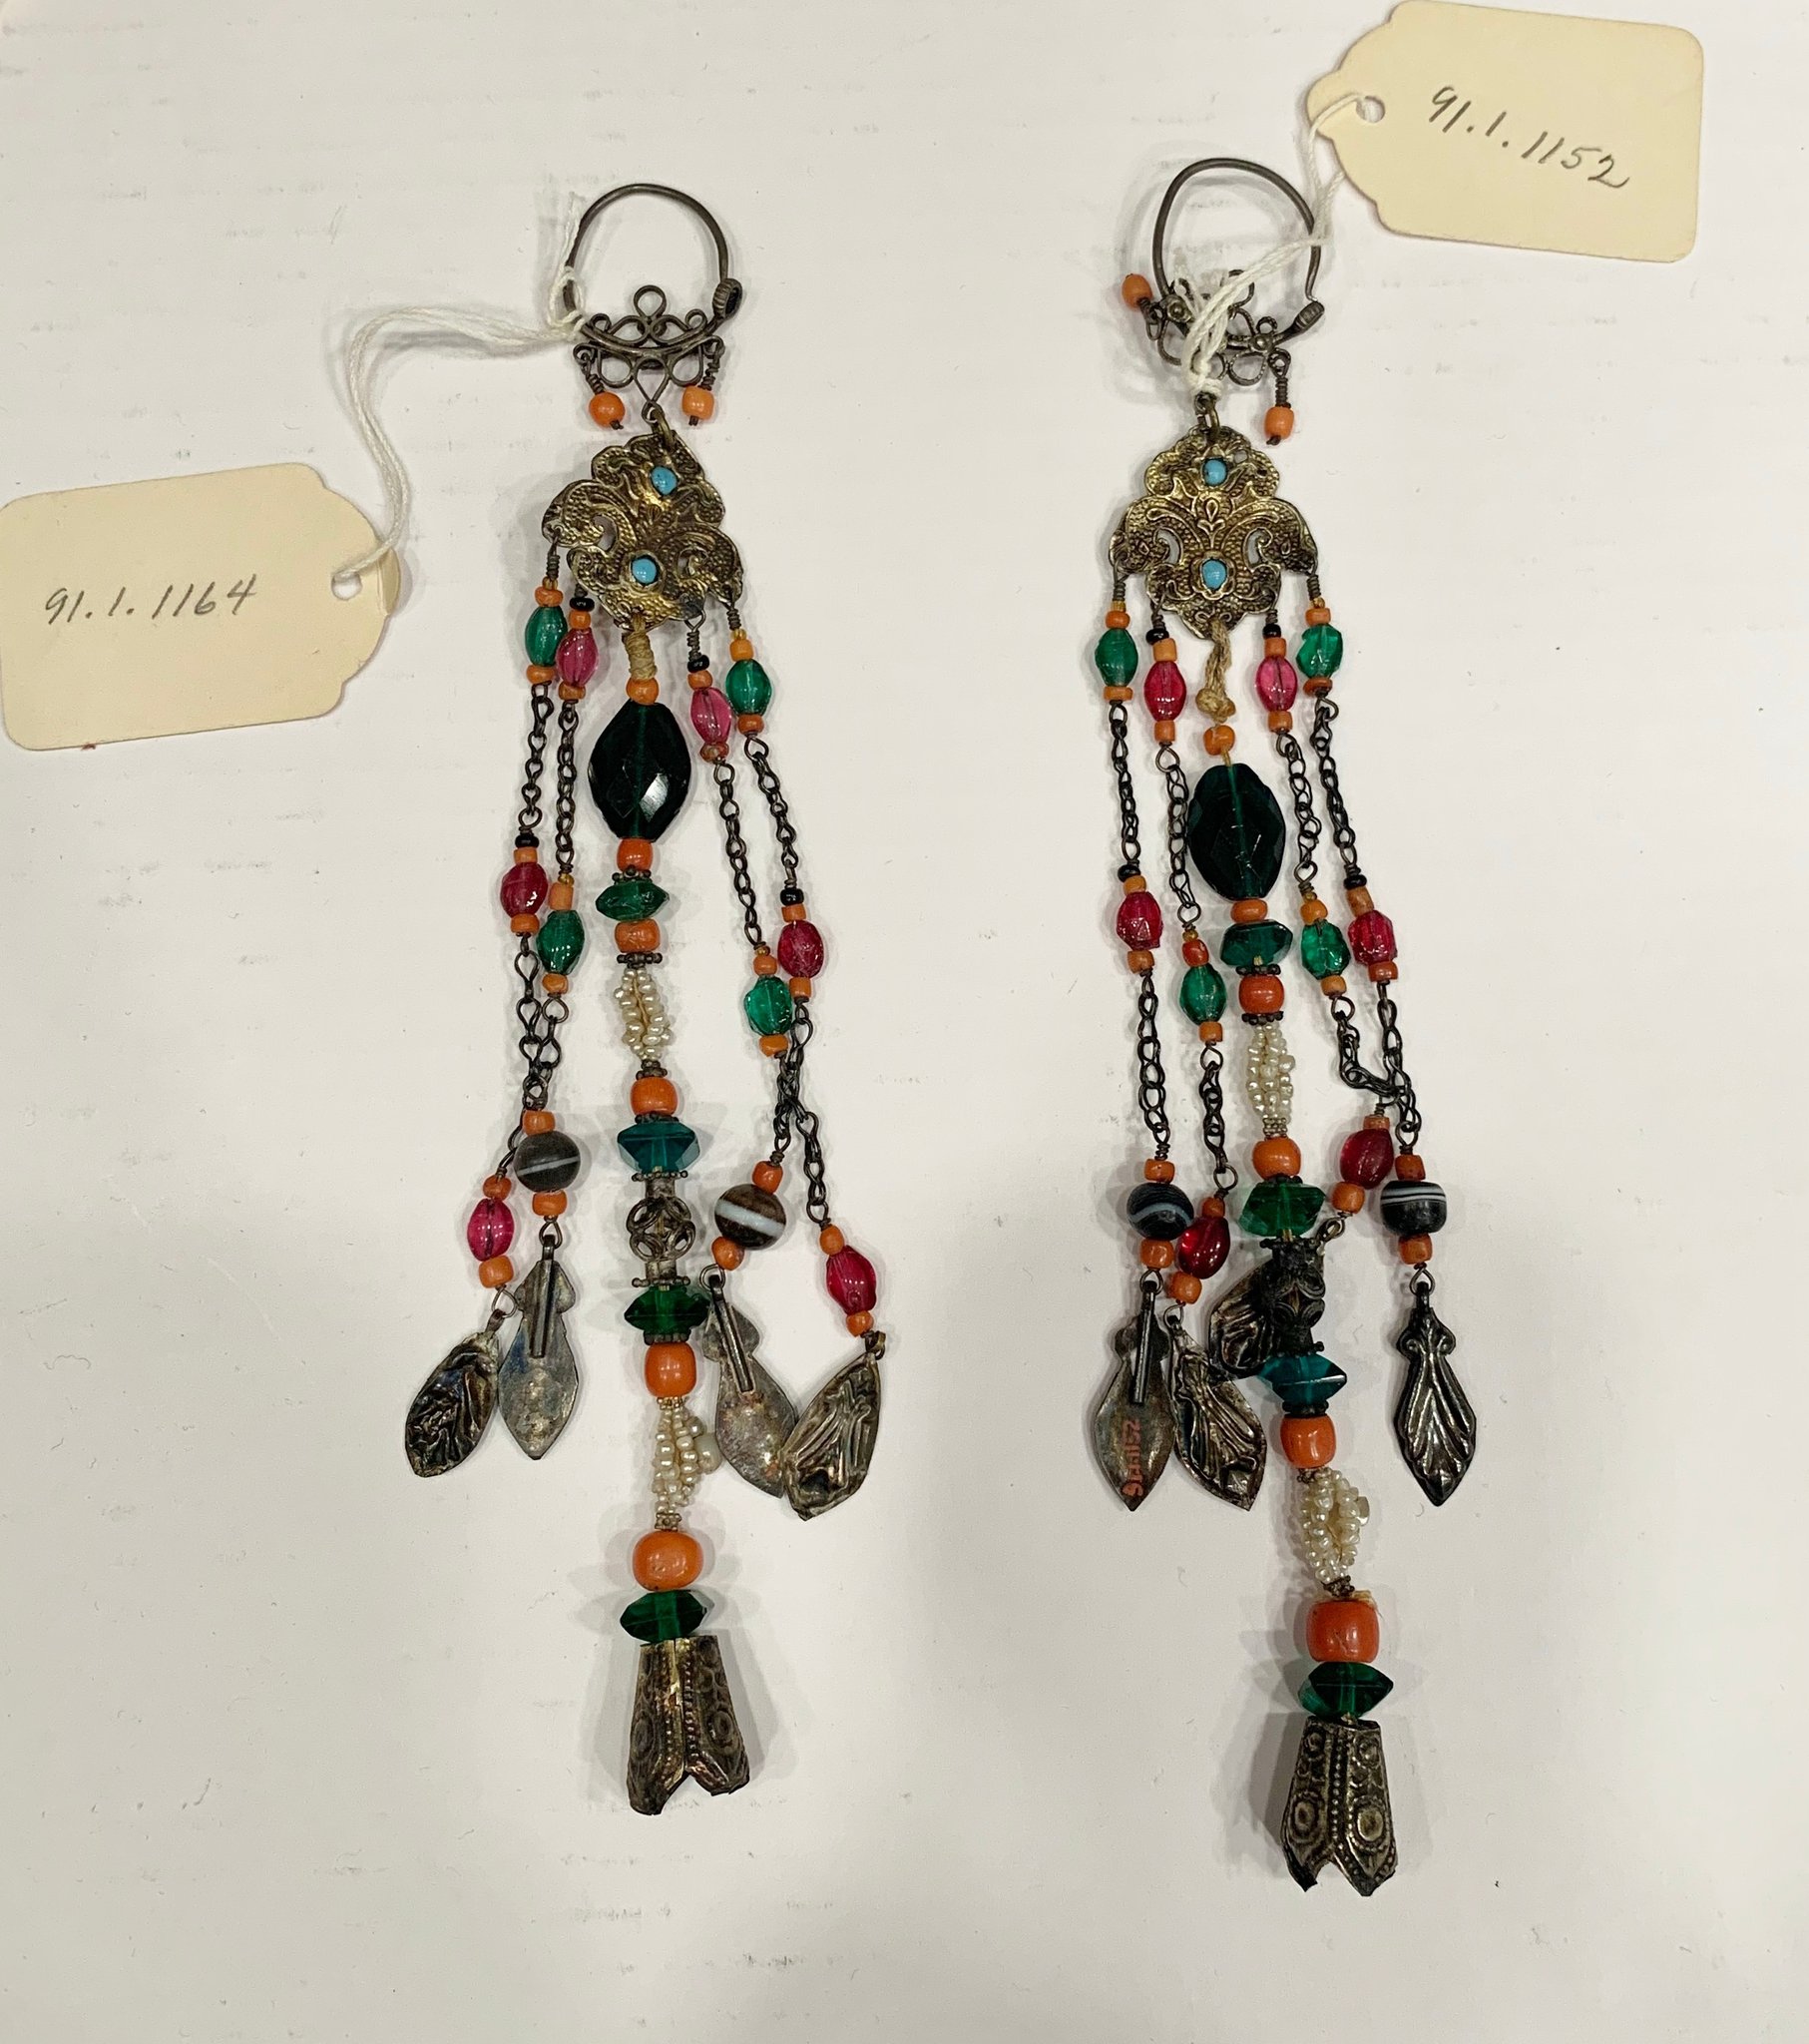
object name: earring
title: Earring, One of a Pair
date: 1801-1900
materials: coral, gold, pearl, silver, stone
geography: uzbekistan